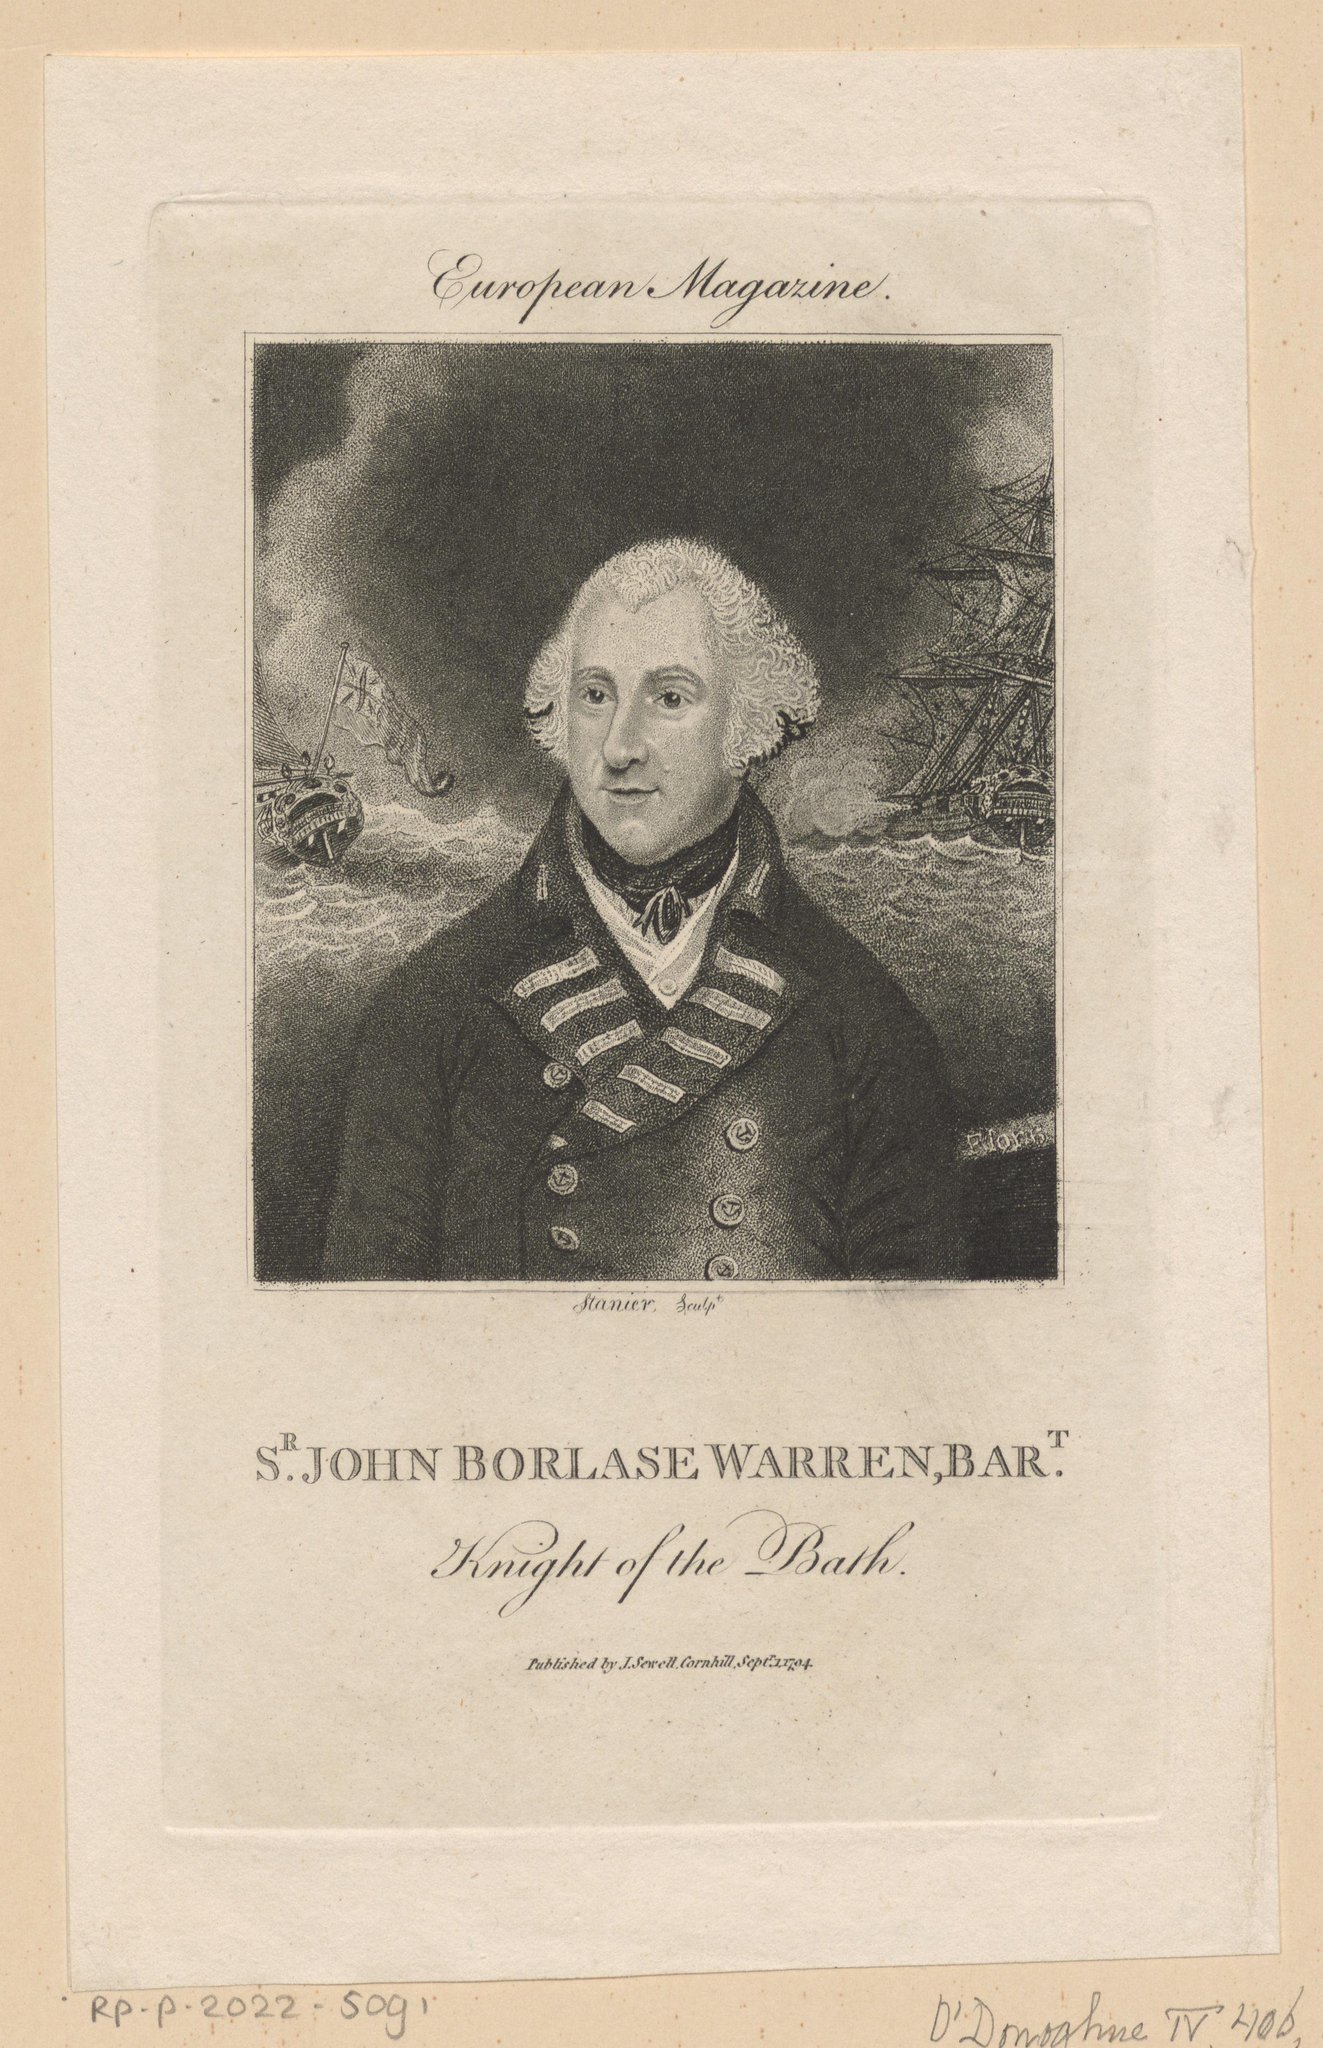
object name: print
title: Portret van John Borlase Warren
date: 1709-1794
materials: paper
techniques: etching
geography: london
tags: politician, historical persons, ships (in general), politician, e.g. party leader, diplomacy, diplomat, commander-in-chief, admiral